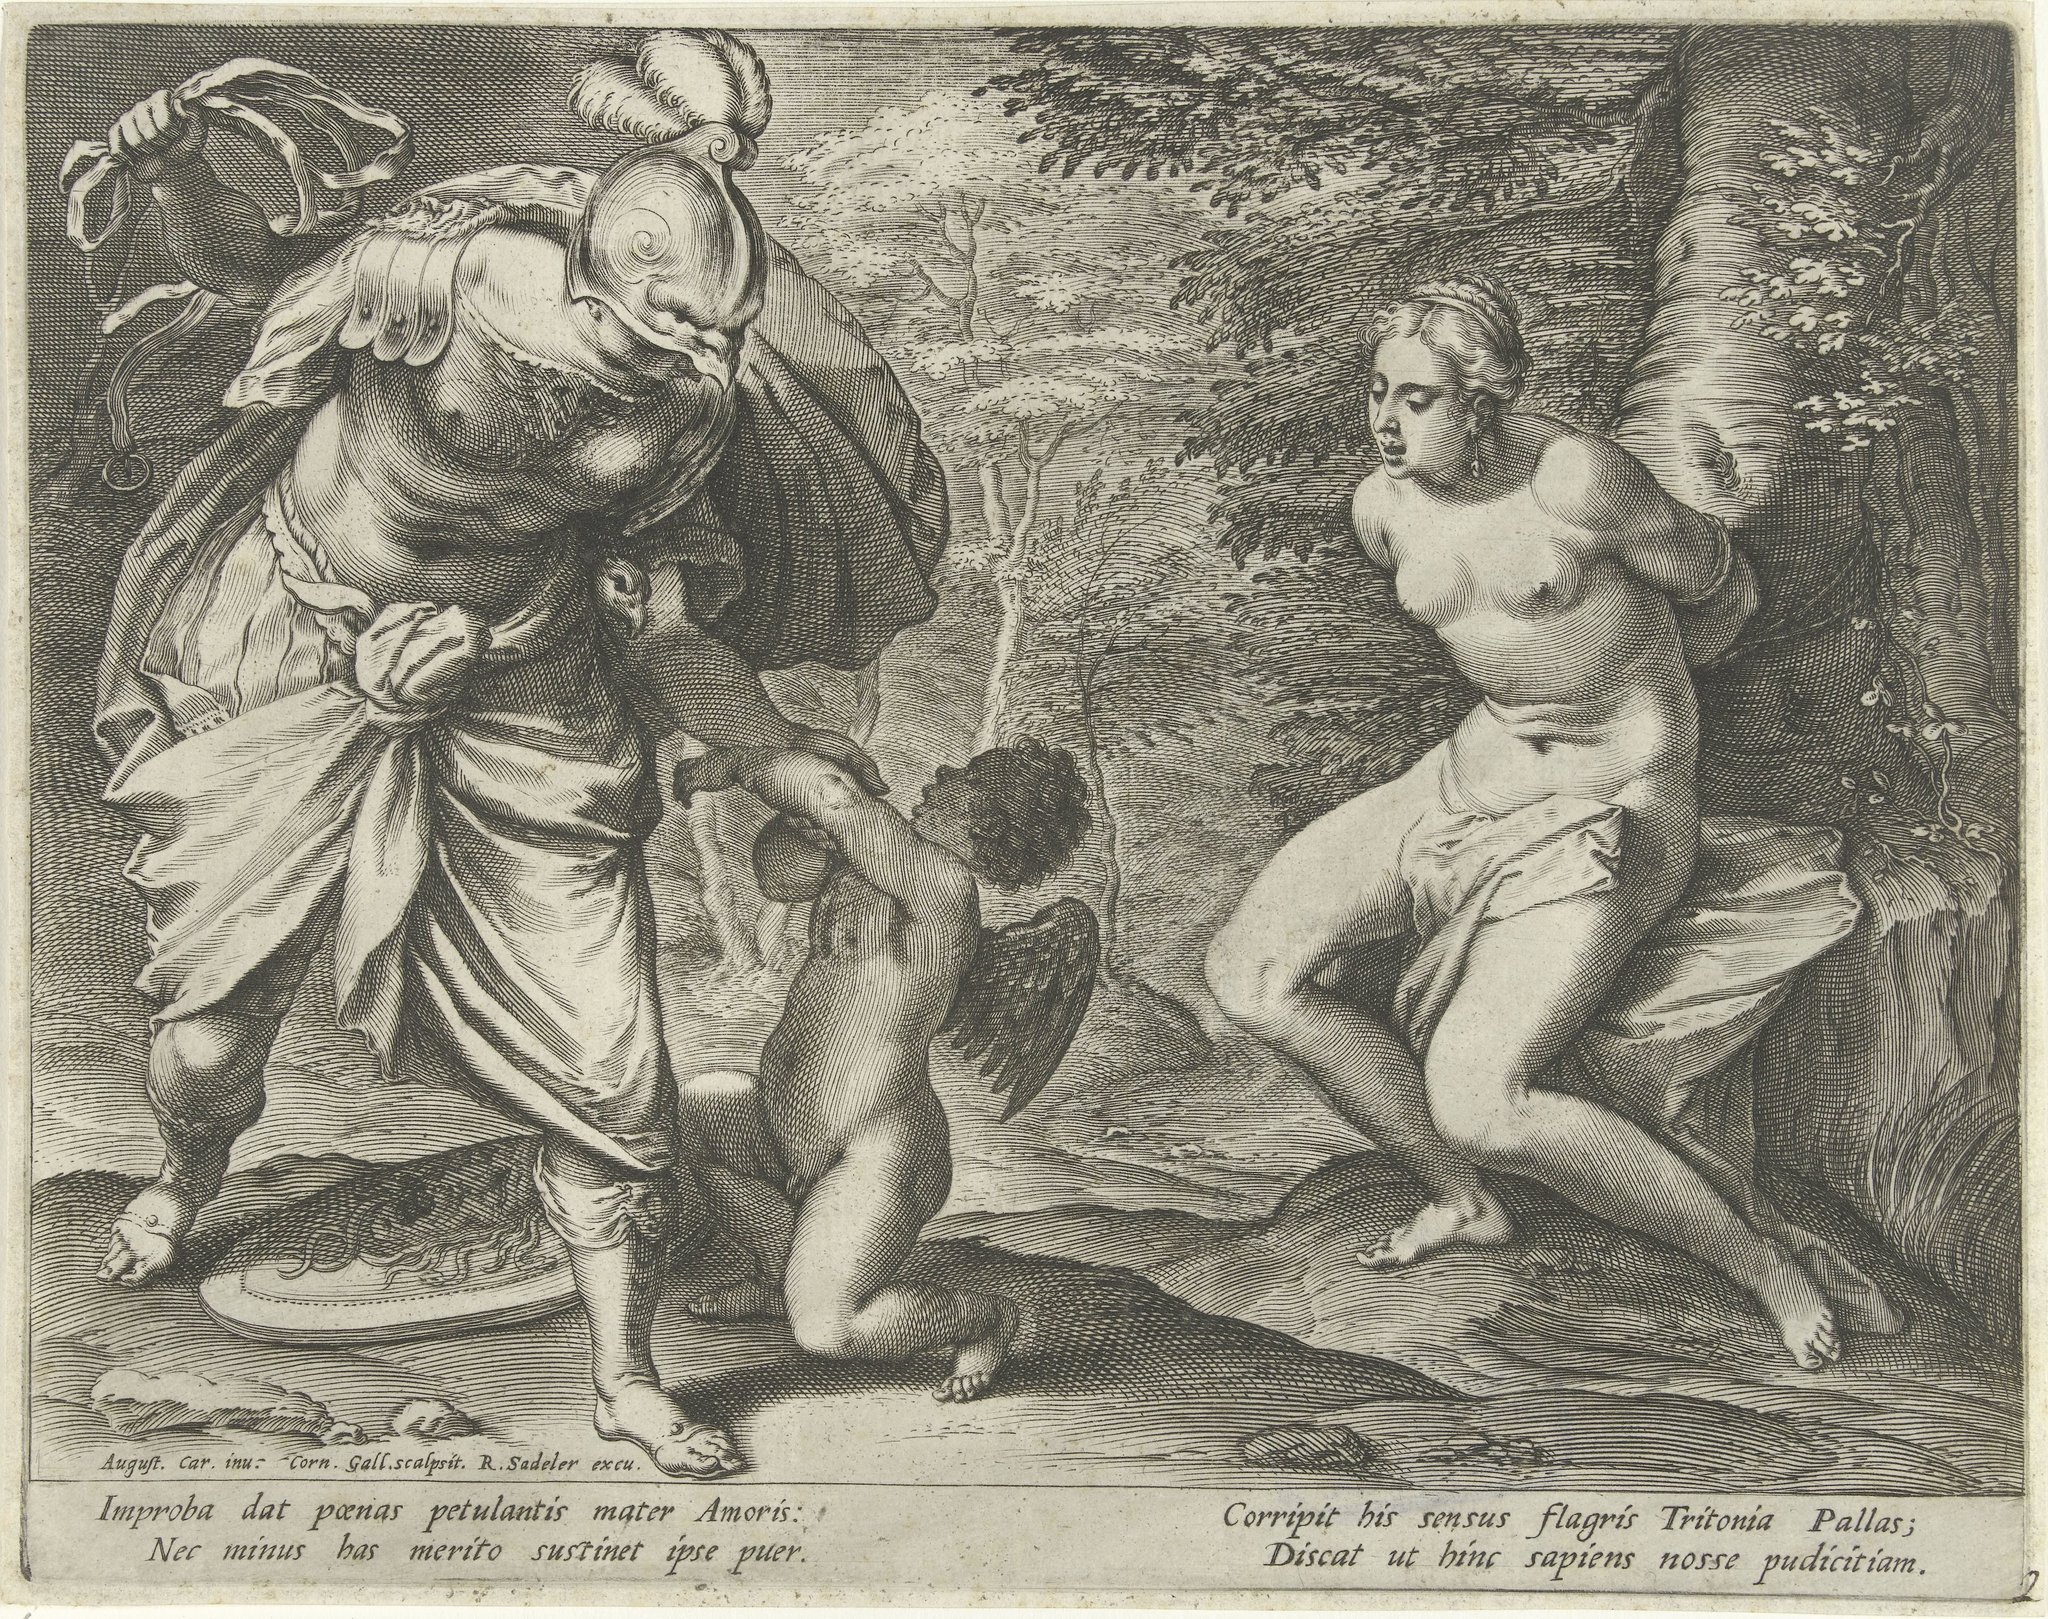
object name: print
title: Venus aan een boom gebonden en Amor door Minerva gestraft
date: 1586-1632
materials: paper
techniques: engraving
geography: southern netherlands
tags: (story of) minerva (pallas, athena), aggressive, unfriendly activities and relationships of minerva, venus and cupid (cupid not being mere attribute)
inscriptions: collector's mark: Lugt 10, number: ‘2’, collector's mark: Lugt 11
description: Venus is met haar handen aan een boom vastgebonden. Minerva trekt Amor aan zijn bovenarm en slaat hem met haar breidel. Haar schild met het Medusahoofd ligt op de grond.